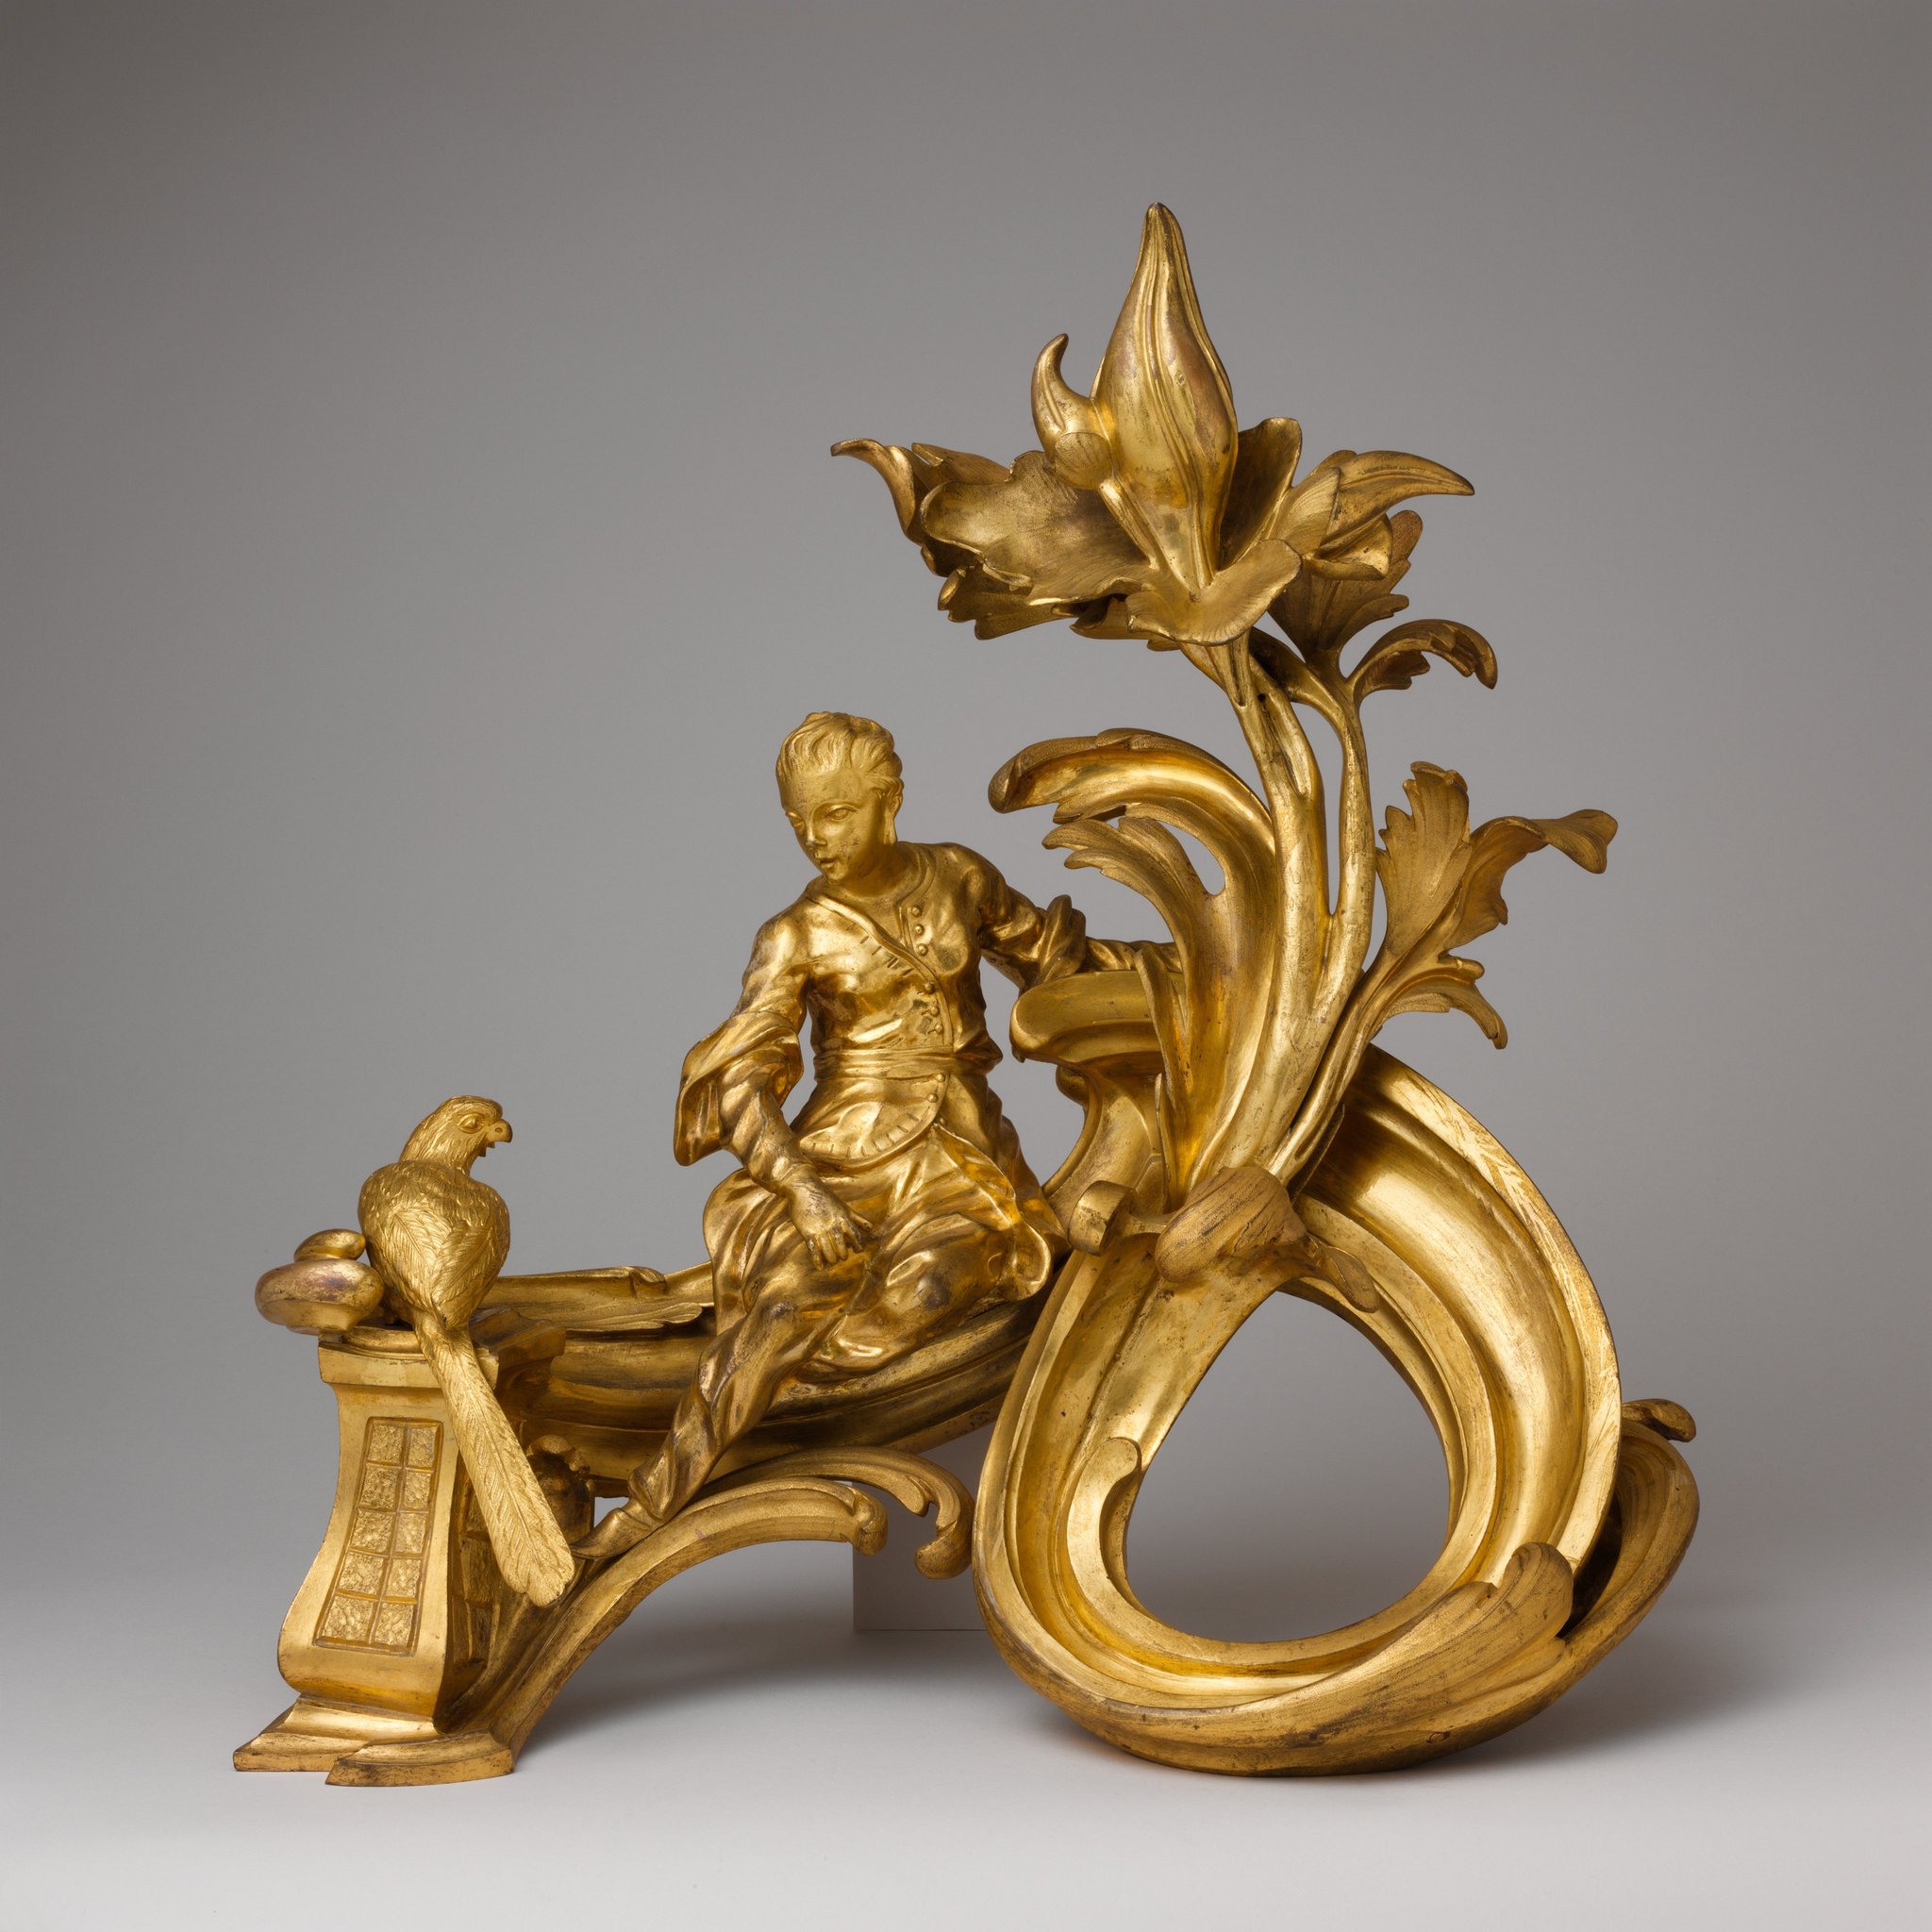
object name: firedog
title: Pair of firedogs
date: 1750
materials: brass, gilt bronze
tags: men,women,parrots